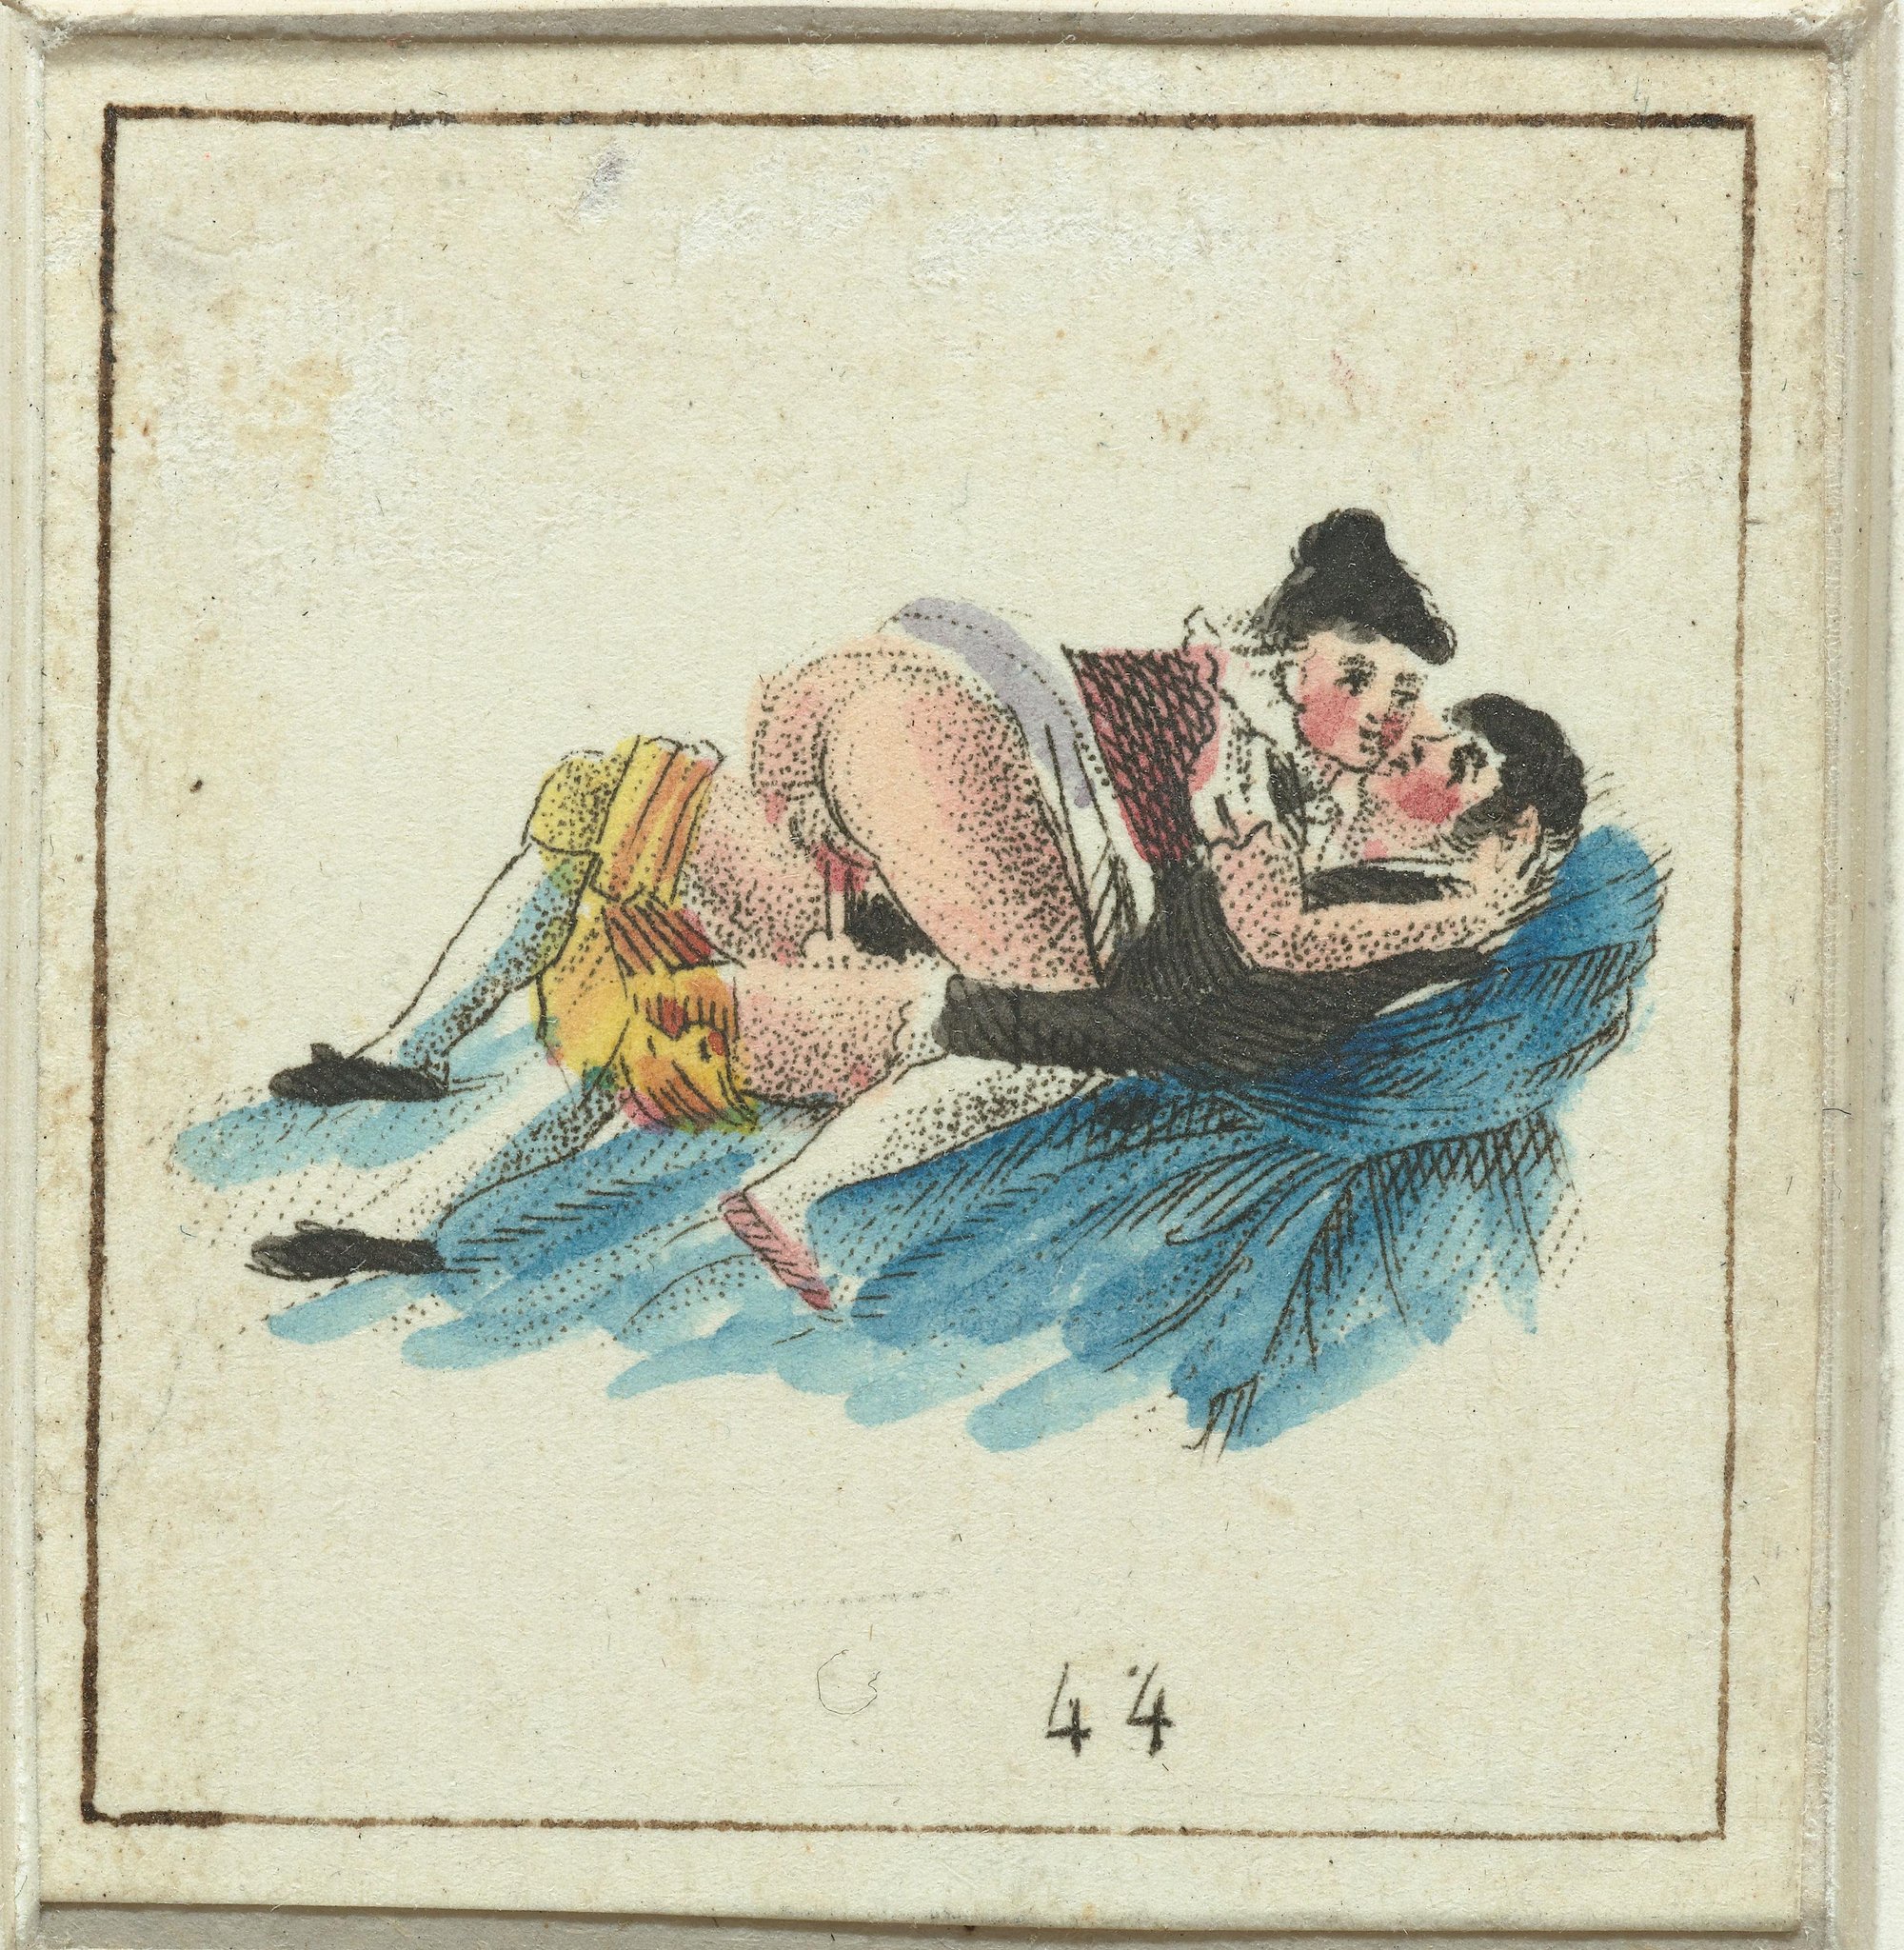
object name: print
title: Vrijend paar, man en vrouw gekleed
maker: Anonymous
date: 1750-1850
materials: paper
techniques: etching, hand coloring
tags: man and woman cohabiting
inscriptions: number: ‘44’